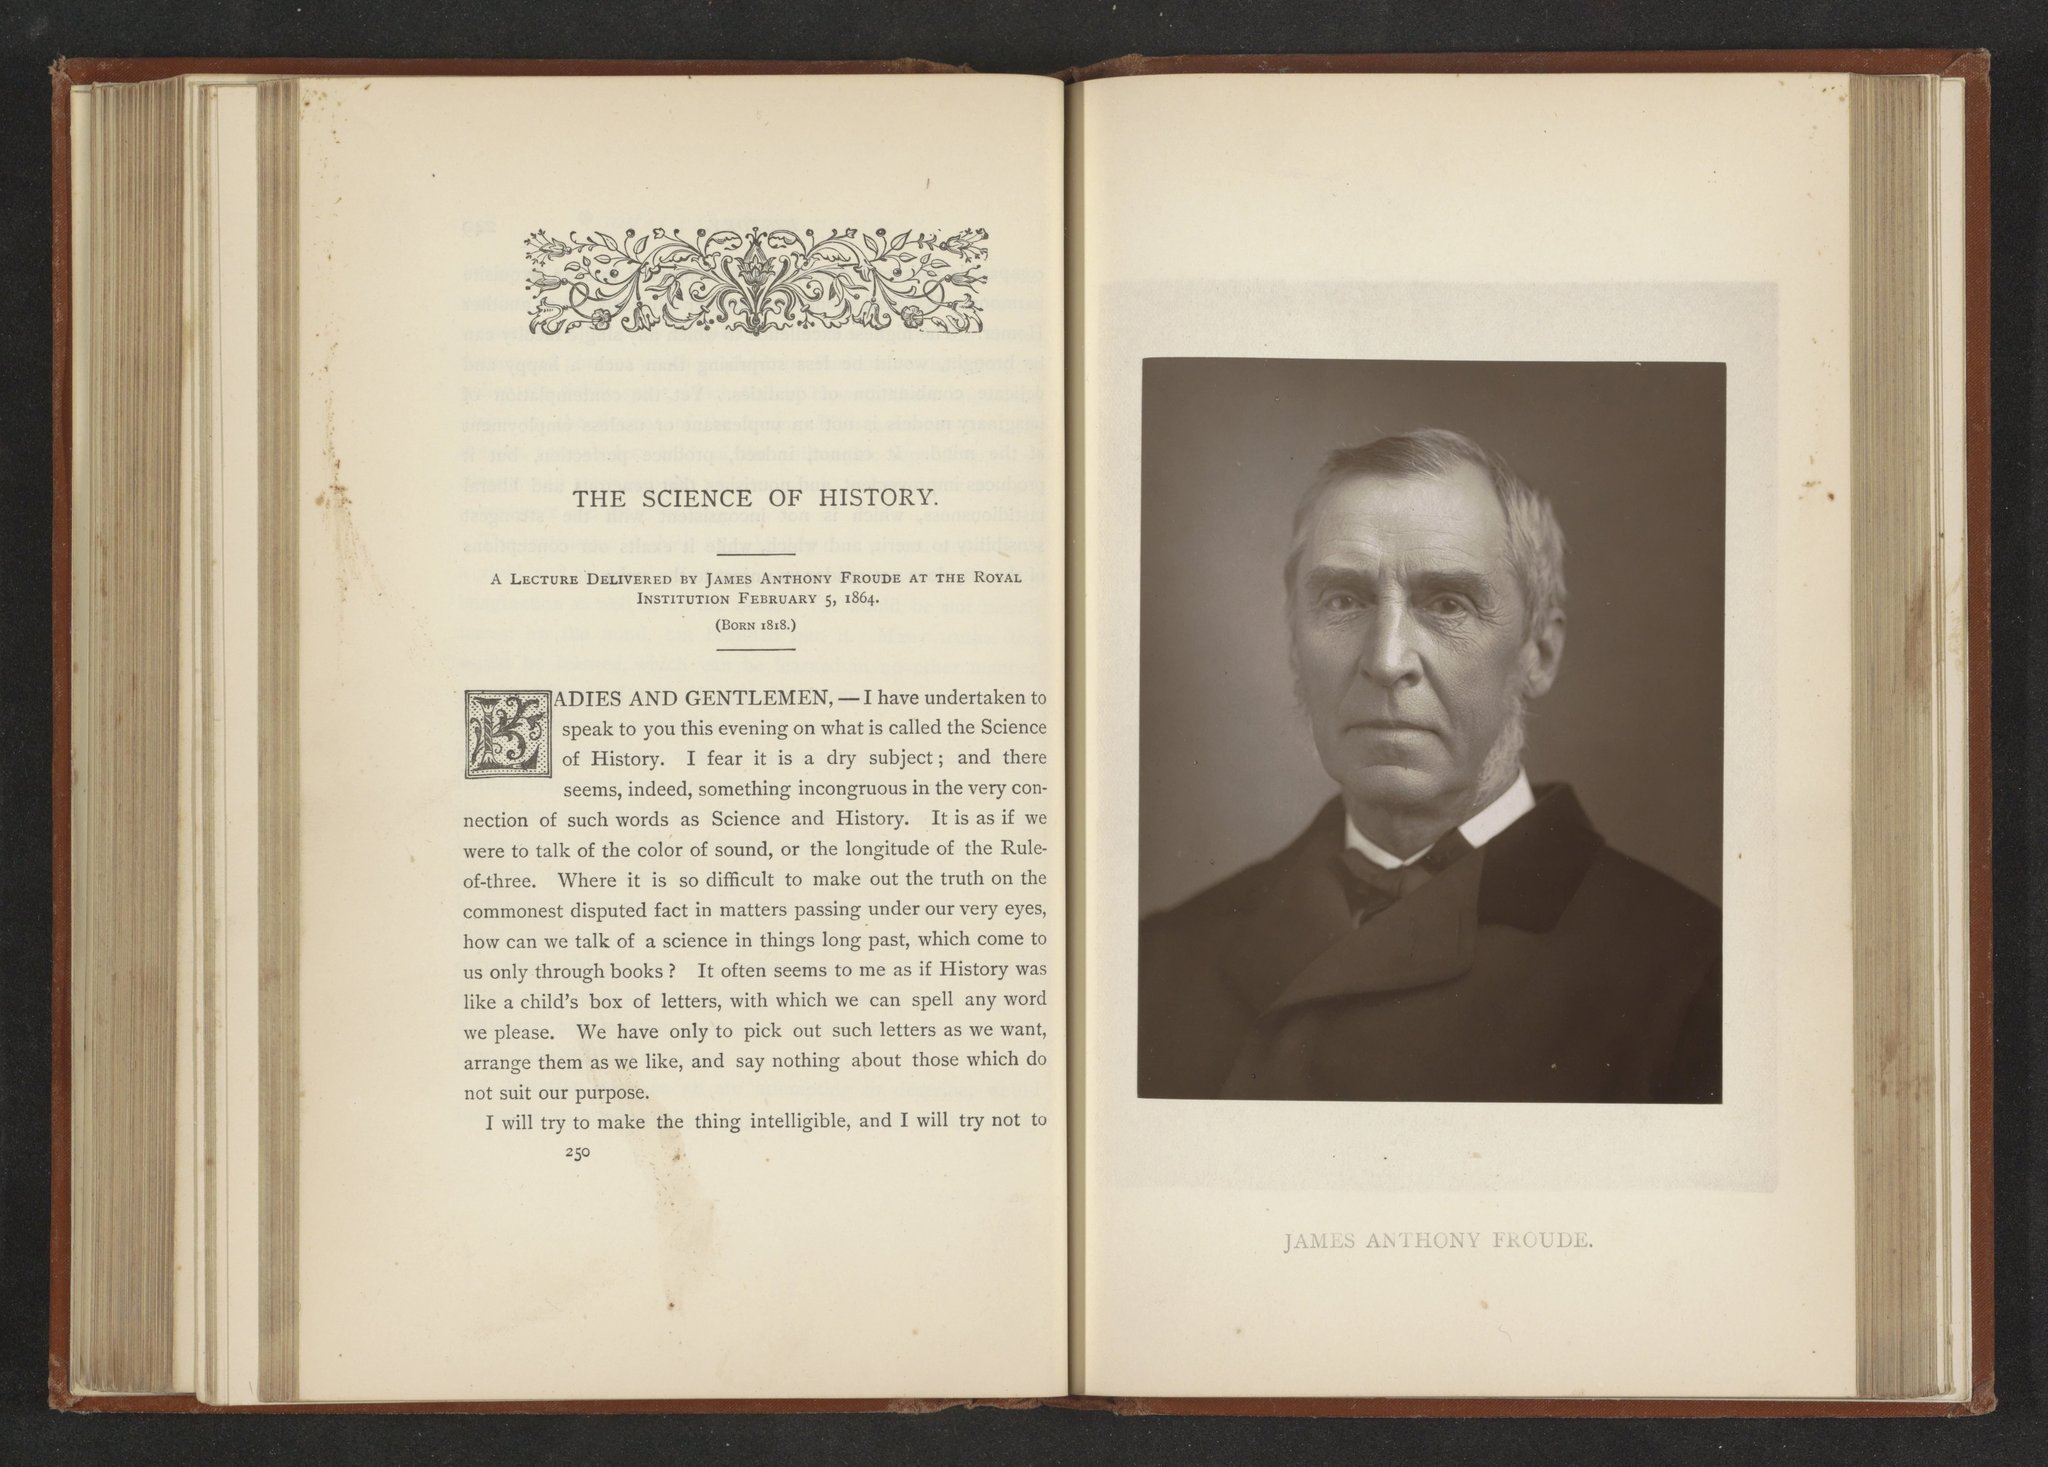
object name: page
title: James Anthony Froude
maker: Anonymous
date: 1876-1886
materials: paper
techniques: woodburytype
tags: portrait of a writer